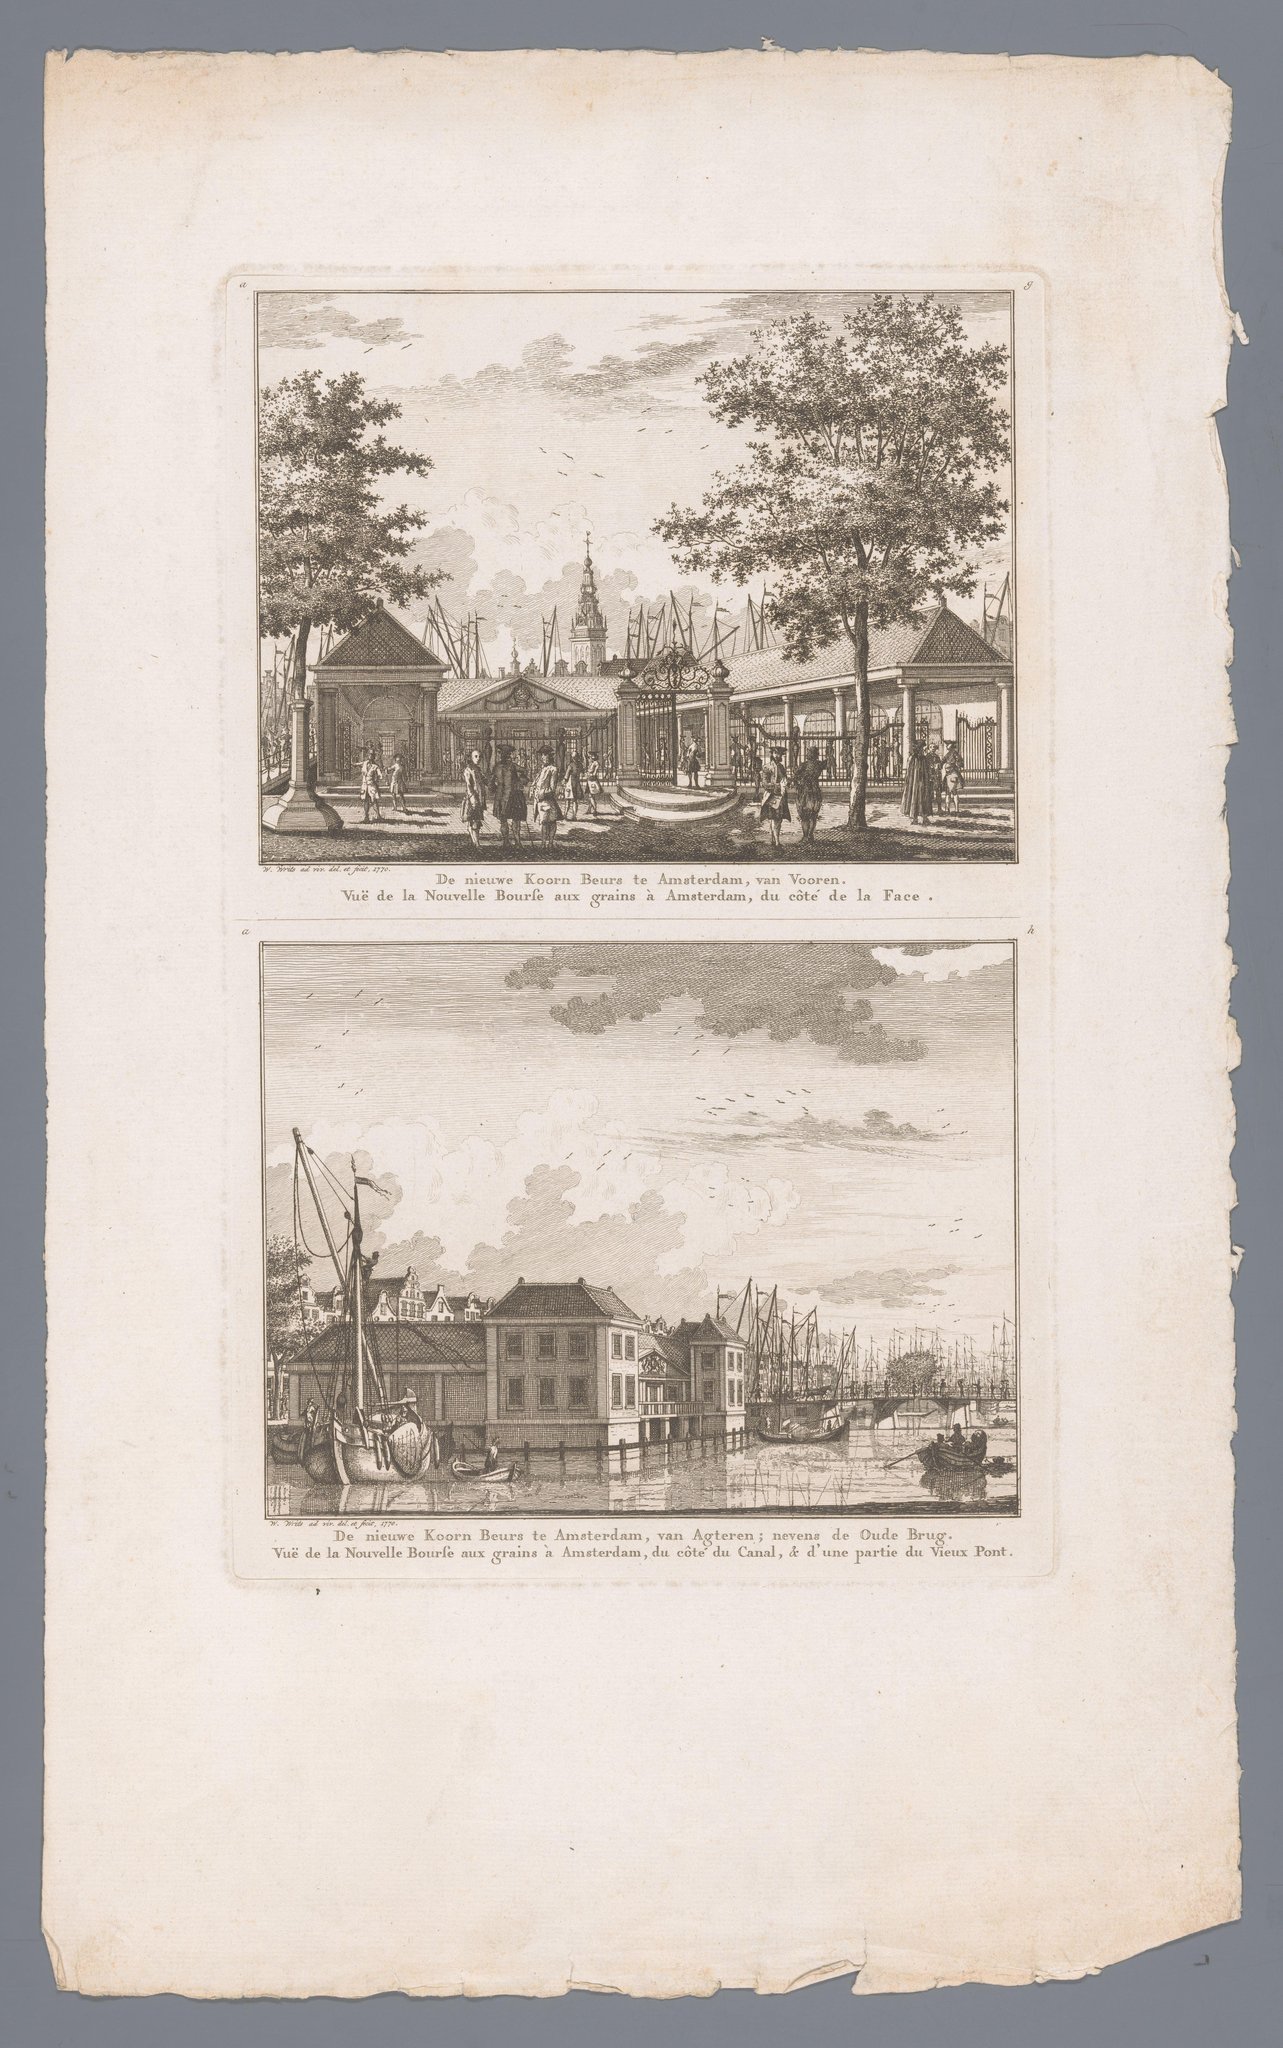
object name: book illustration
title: De nieuwe koorn beurs te Amsterdam, van vooren / Vuë de la nouvelle bourse aux grains à Amsterdam, du côté de la face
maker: willem writs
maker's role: draughtsman, print maker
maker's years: 1731-1786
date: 1804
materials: paper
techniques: etching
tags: sailing-ship, sailing-boat, tower, clock tower ~ monumental adornment, market-hall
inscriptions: collector's mark: Lugt 2233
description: Prent uit: Elwe, Jan Barend. Atlas van de wereldberoemde koopstad Amsteldam (...). Amsterdam: Jan Barend Elwe, 1804. Later zijn deze prenten ook uitgegeven in Atlas: of, verzameling van afbeeldingen der voornaamste gebouwen, torens en gezichten der stad Amsterdam, voor kinderen. Amsterdam: H. Moolenijzer, [1824], dl. 1, pl. 1 en 2.